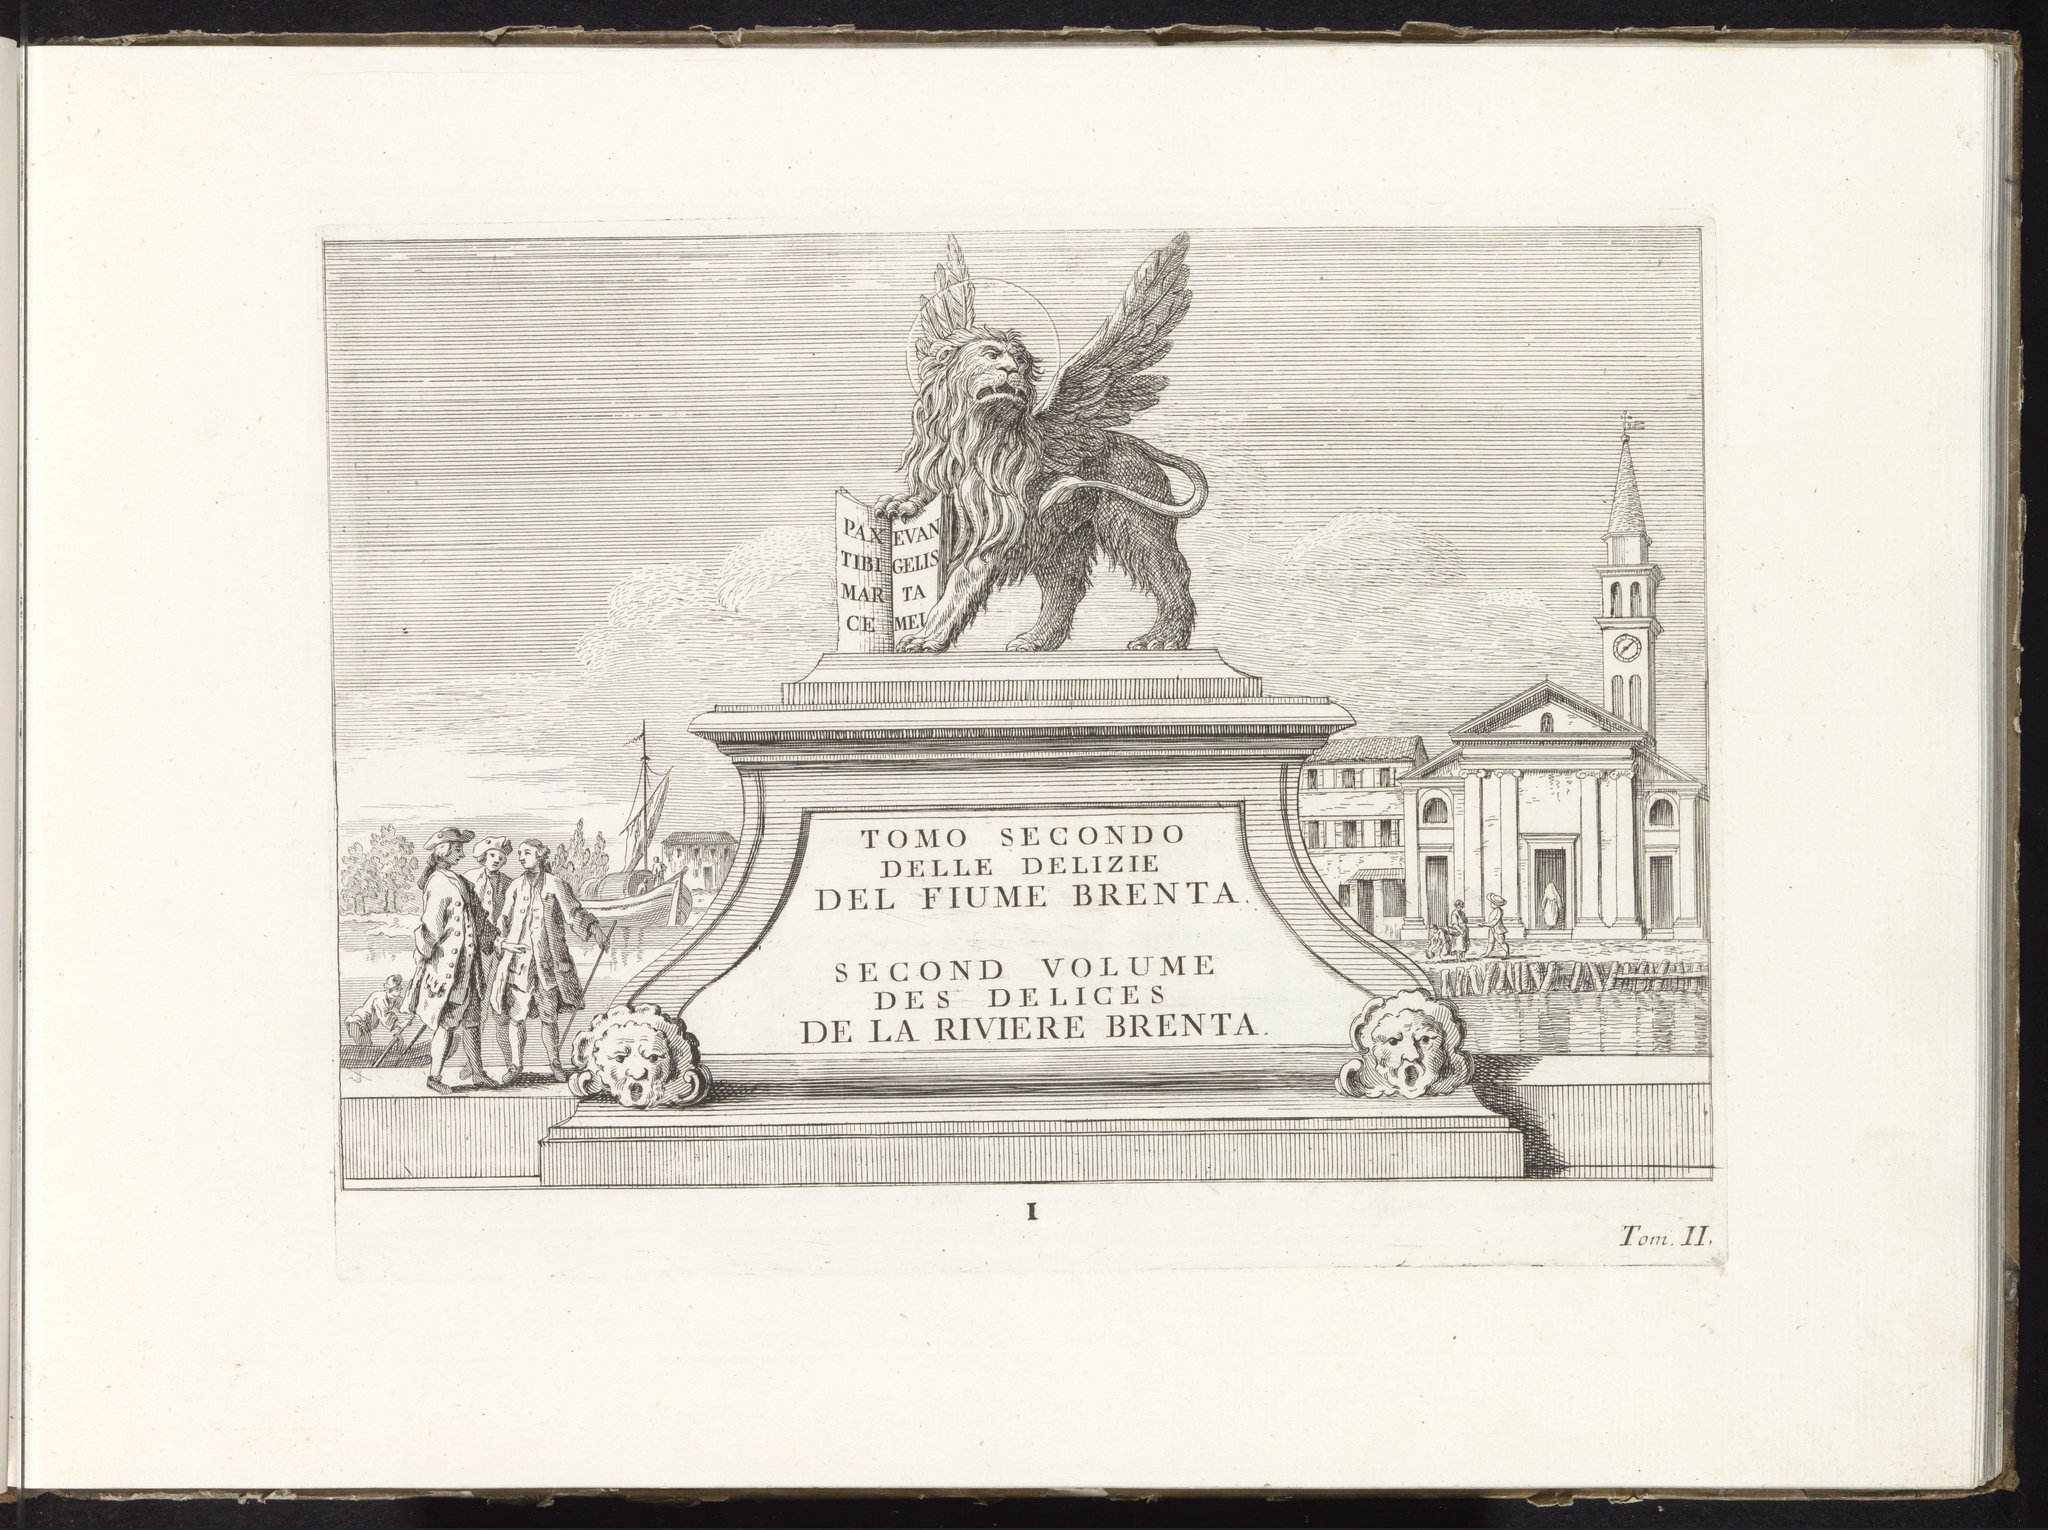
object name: titelprent, frontispice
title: Tomo secondo delle delizie del fiume Brenta/ Secons volume des delices de la riviere Brenta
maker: giovanni francesco costa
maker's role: draughtsman, painter, print maker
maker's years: -1773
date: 1750-1760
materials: paper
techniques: etching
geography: italy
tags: river, church (exterior), piece of sculpture, reproduction of a piece of sculpture, beasts of prey, predatory animals: lion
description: Sculptuur van de gevleugelde leeuw van de heilige Markus op een basis met titels in het Italiaans en het Frans. Links drie mannen in gesprek. Rechts een kerk aan het water. Genummerd midden onder: I en rechtsonder: Tom: II. Deze prent maakt deel uit van een album.